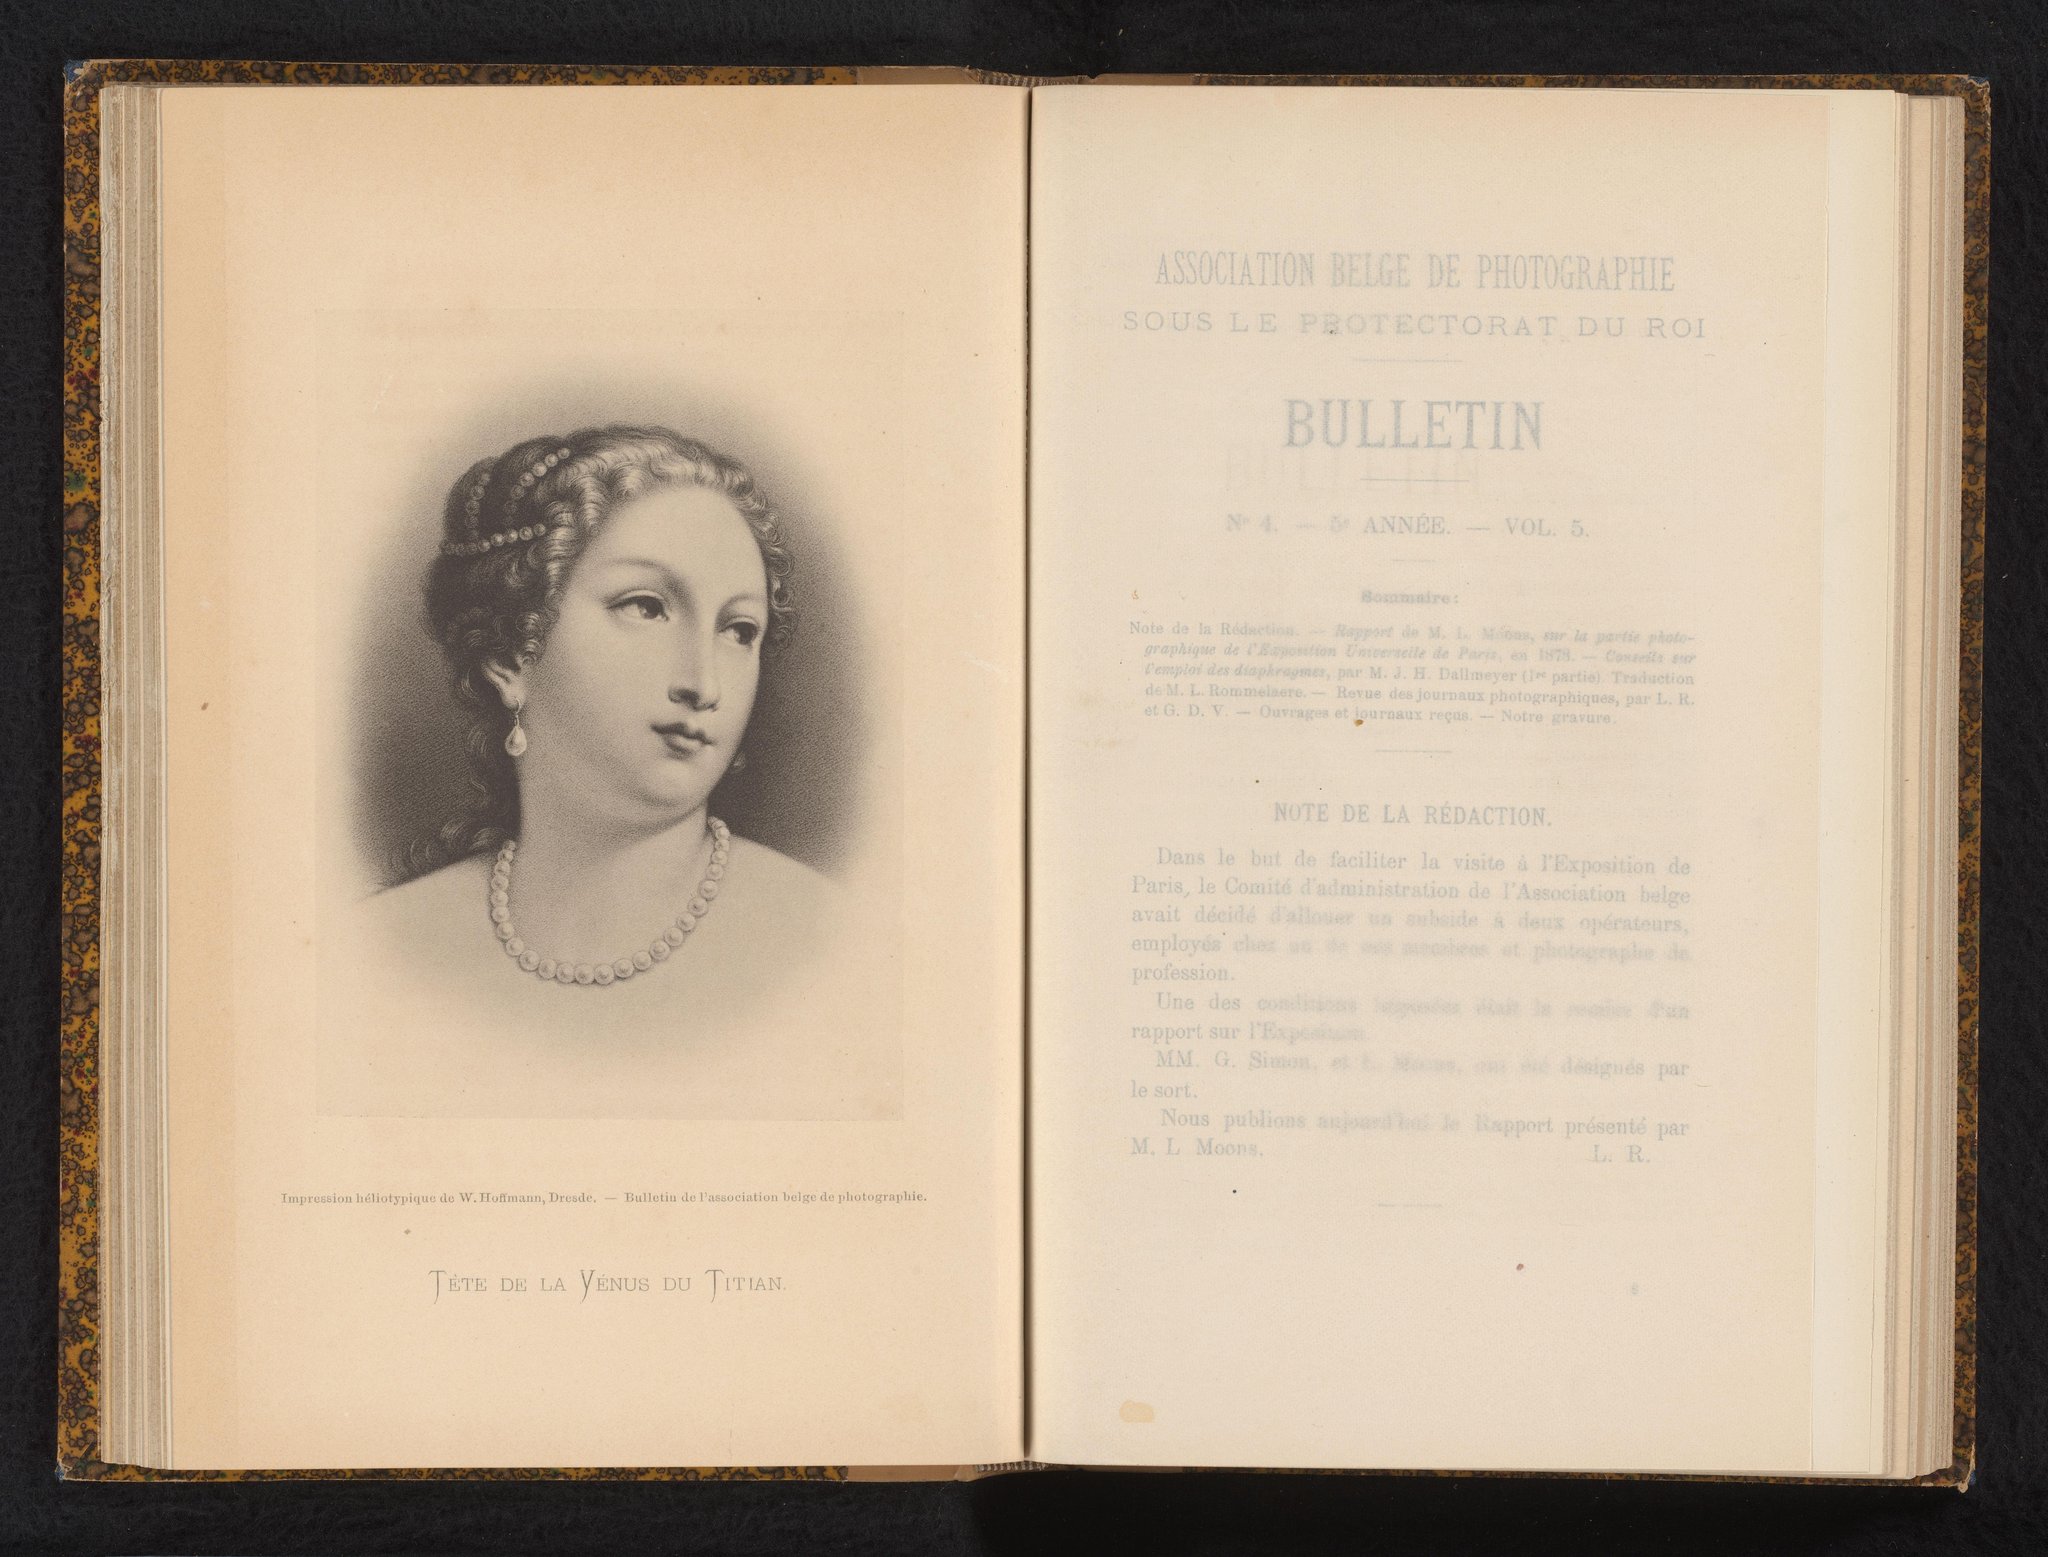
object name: page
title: Sculptuur van de badende Venus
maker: Anonymous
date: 1878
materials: paper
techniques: woodburytype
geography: dornach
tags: bath of venus, piece of sculpture, reproduction of a piece of sculpture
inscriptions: inscription: ‘Woodburytypie’